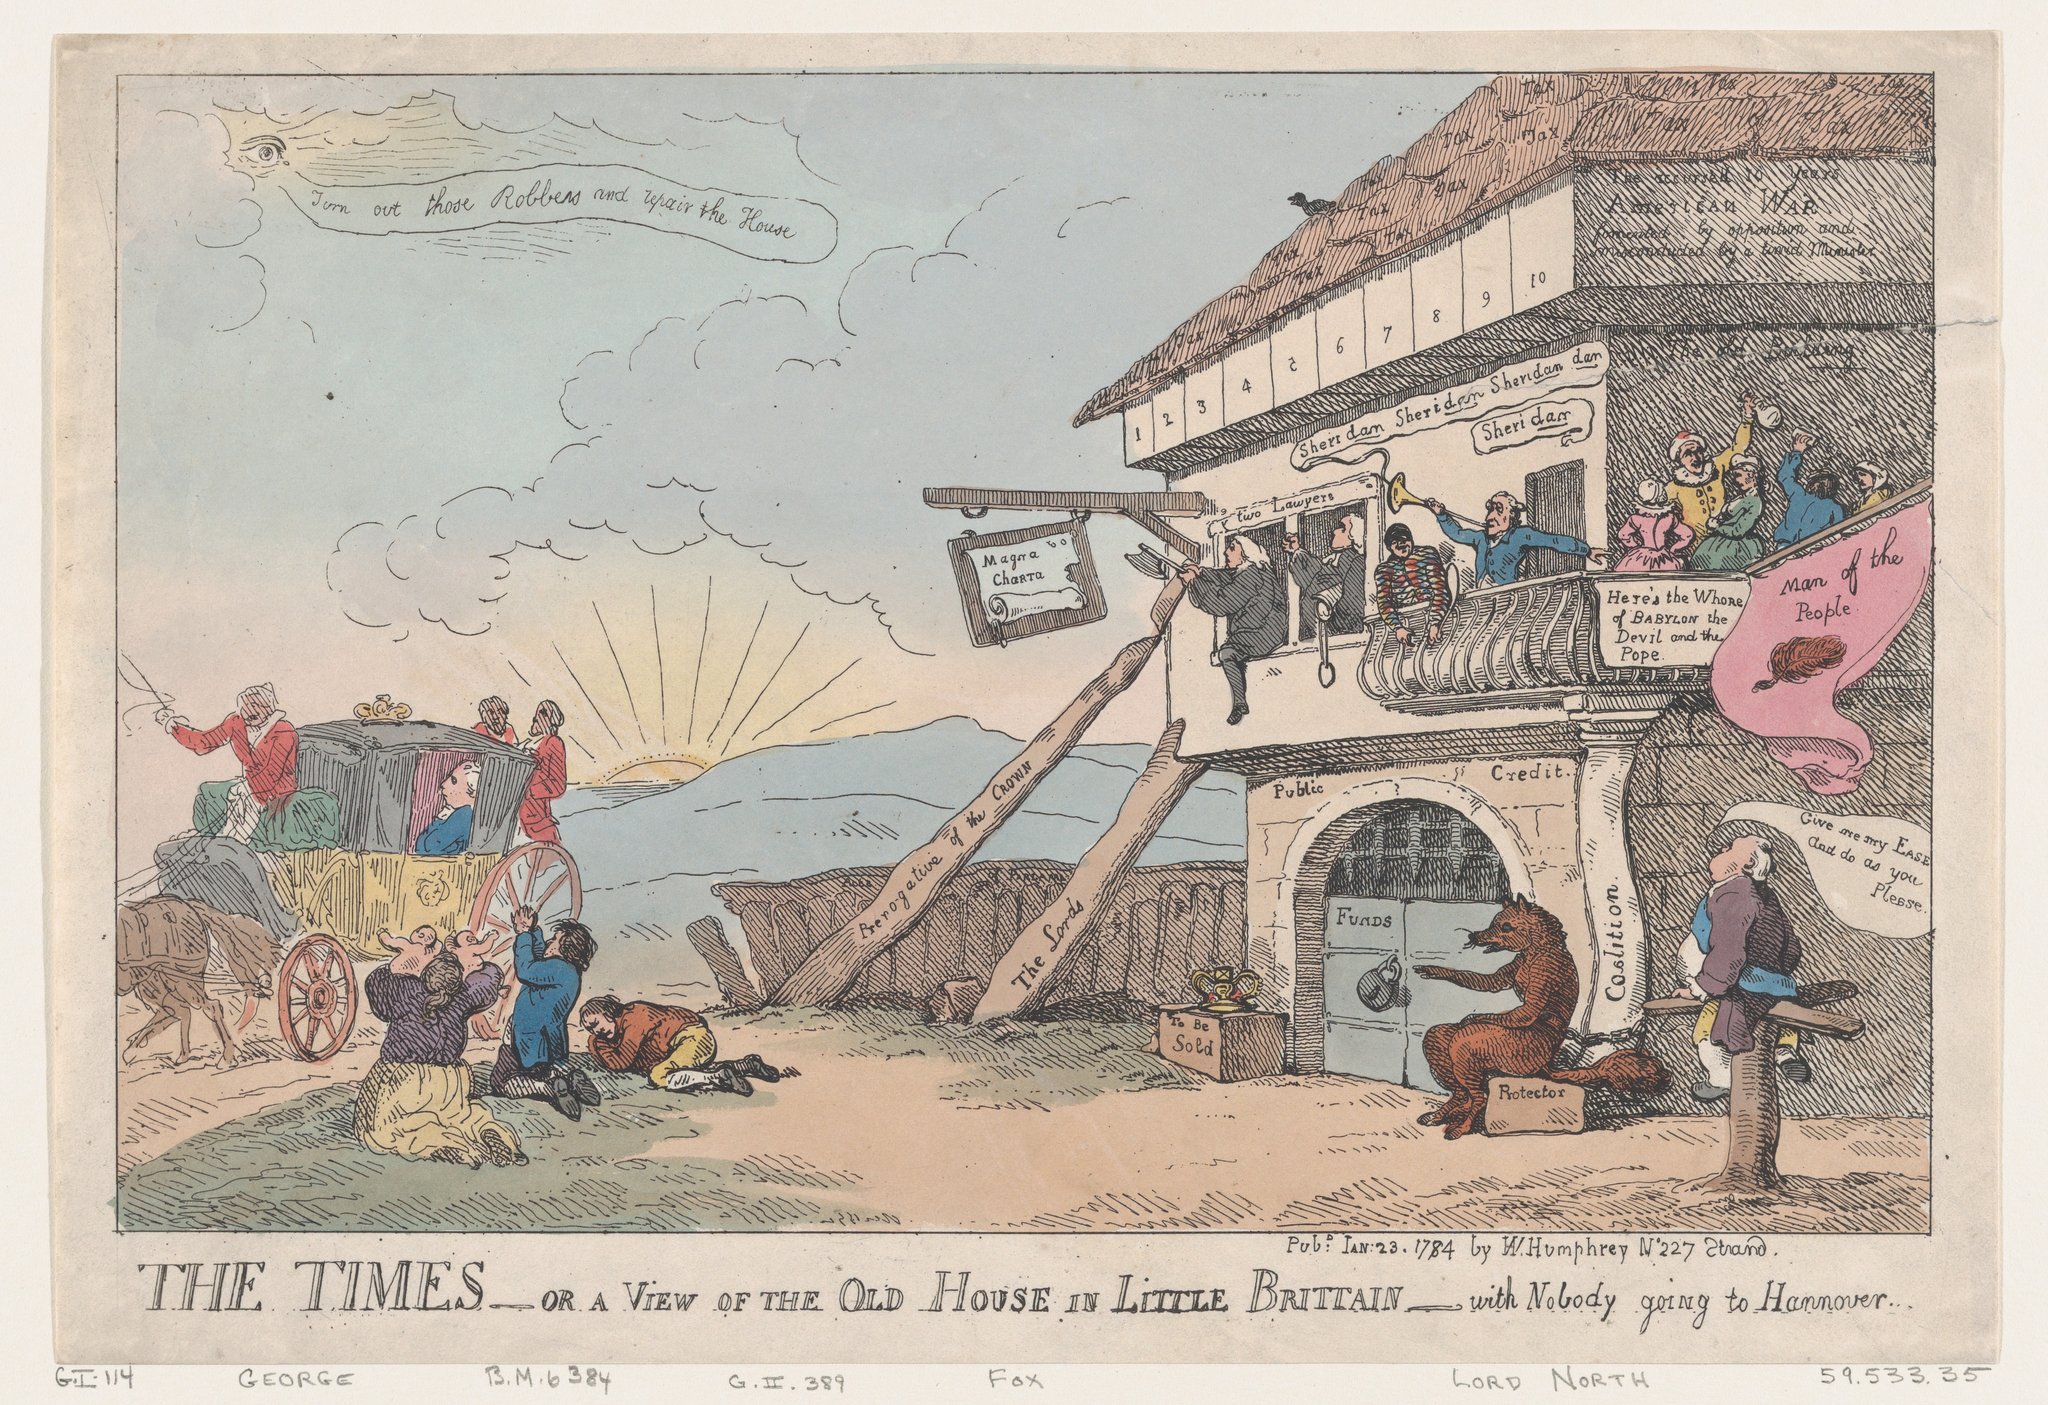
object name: print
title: The Times - Or A View Of The Old House In Little Brittain - With Nobody Going To Hannover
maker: thomas rowlandson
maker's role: artist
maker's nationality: british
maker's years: 1757-1827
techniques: etching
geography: london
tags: human figures,satire,houses,carriages